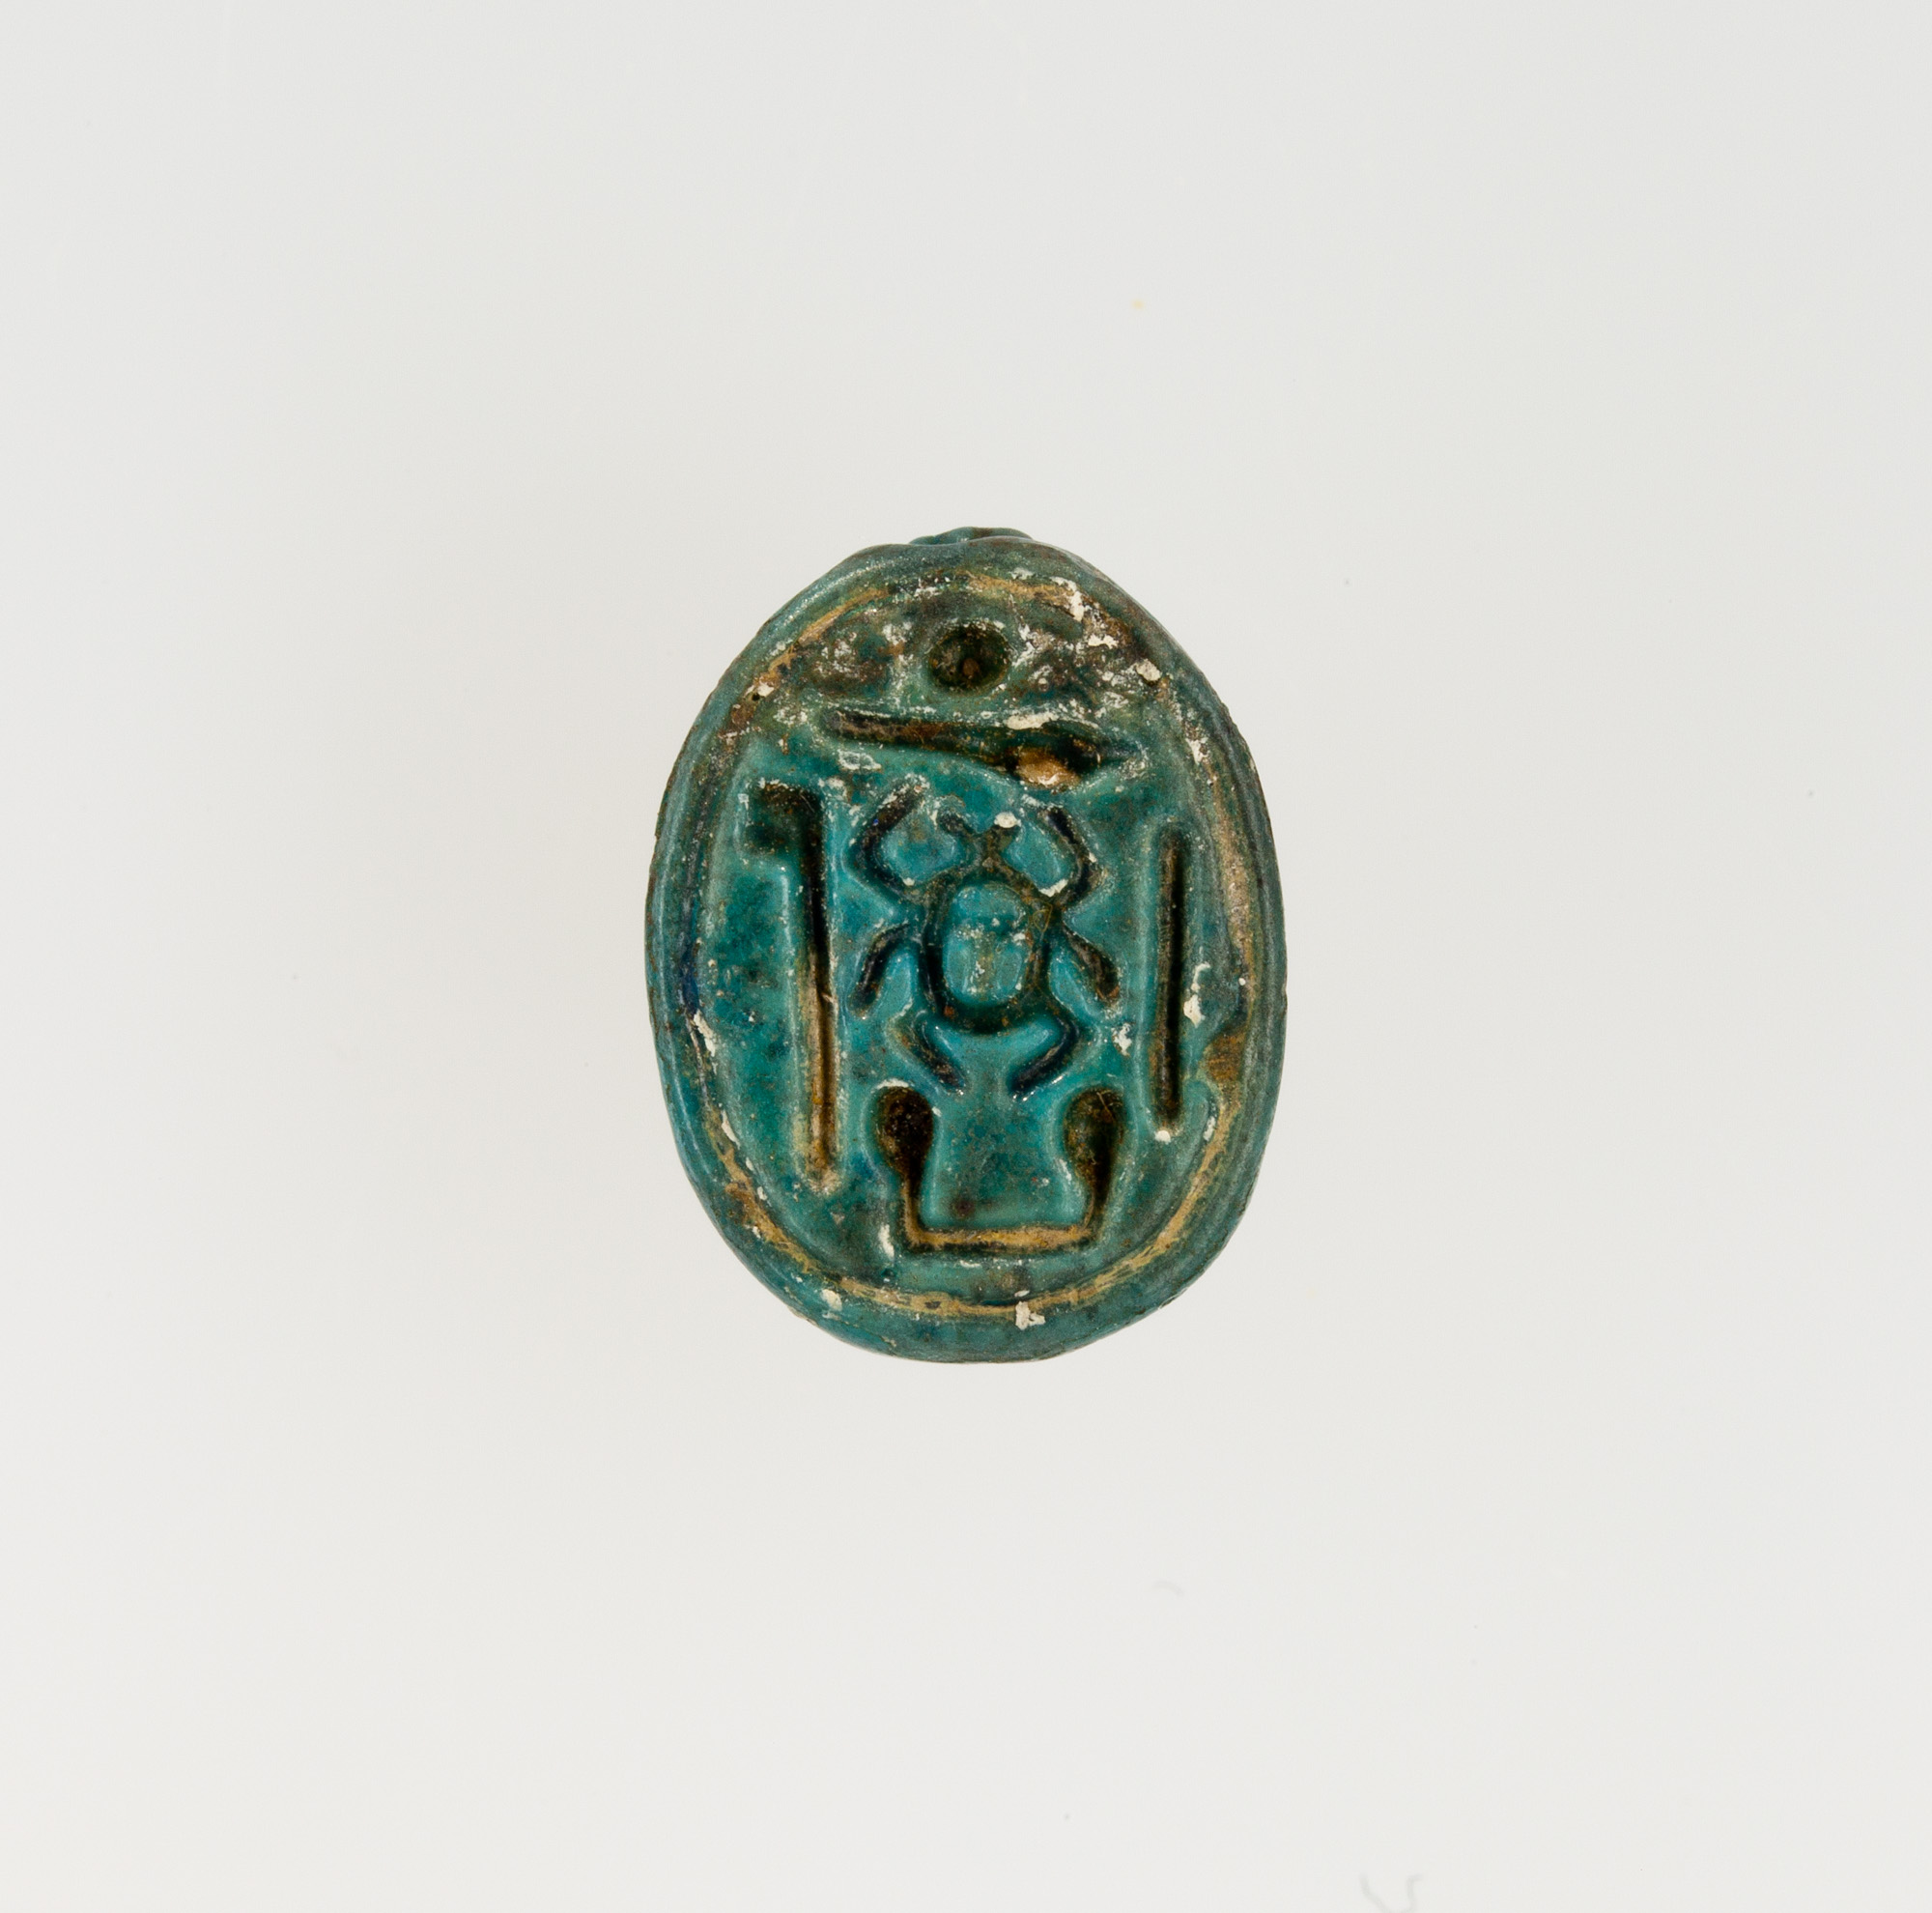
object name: scarab, thutmose i, aakheperkare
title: Scarab Inscribed with the Throne Name of Thutmose I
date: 1504-1492 BCE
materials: stone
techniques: glazing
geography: egypt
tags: hieroglyphs,scarabs